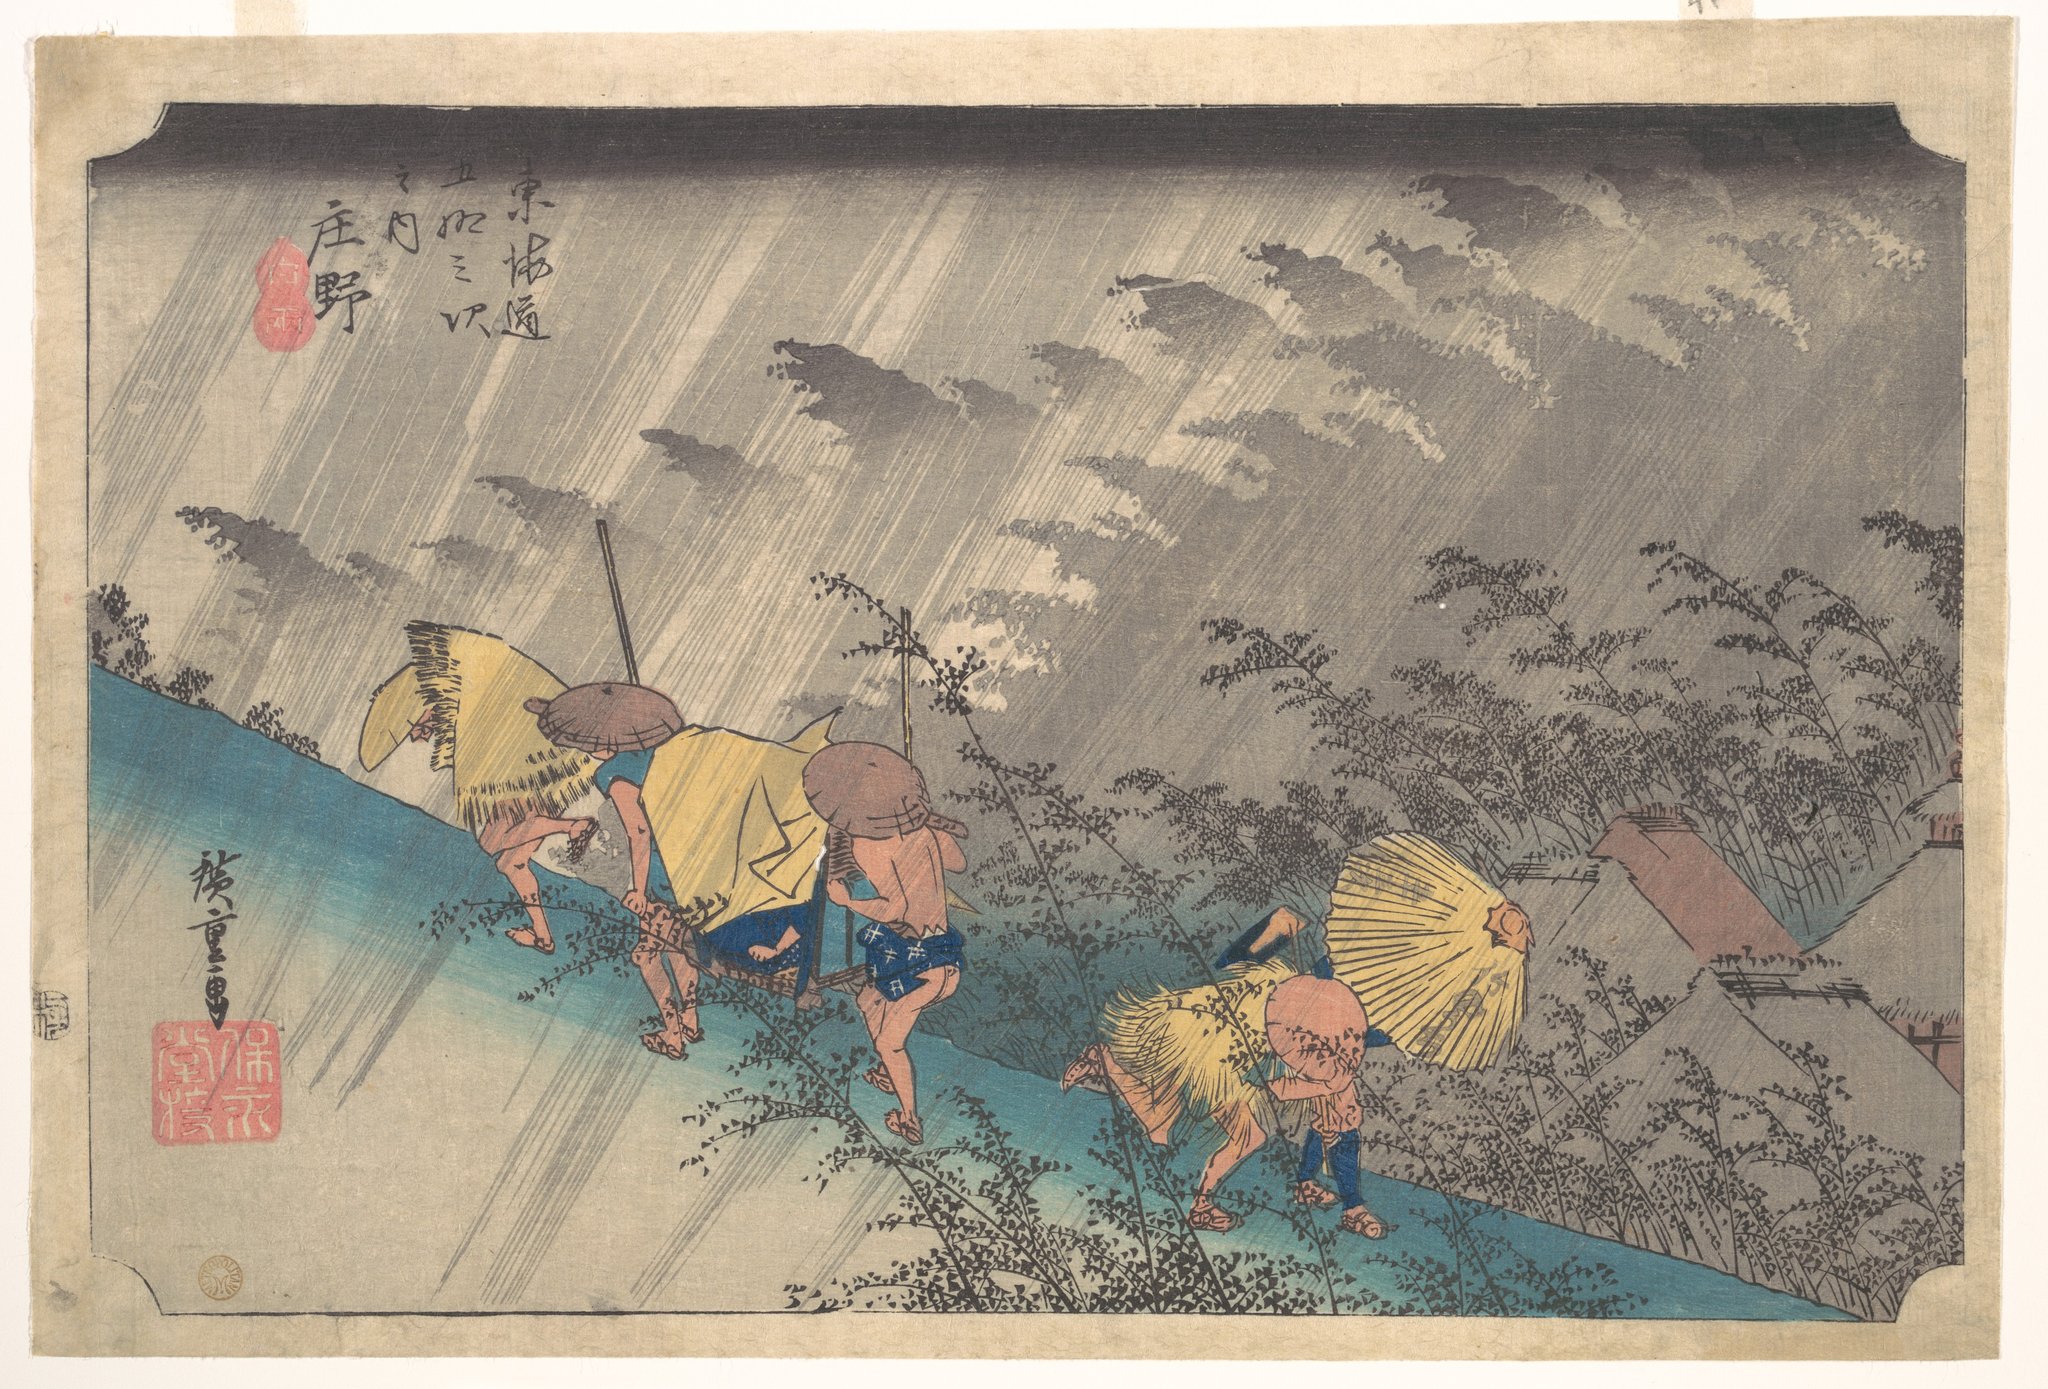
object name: print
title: Sudden Shower at Shōno, from the series Fifty-three Stations of the Tōkaidō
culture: japanese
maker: utagawa hiroshige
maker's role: artist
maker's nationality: japanese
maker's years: 1797-1858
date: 1834-1835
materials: ink, paper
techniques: woodblock print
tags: human figures,trees,rain